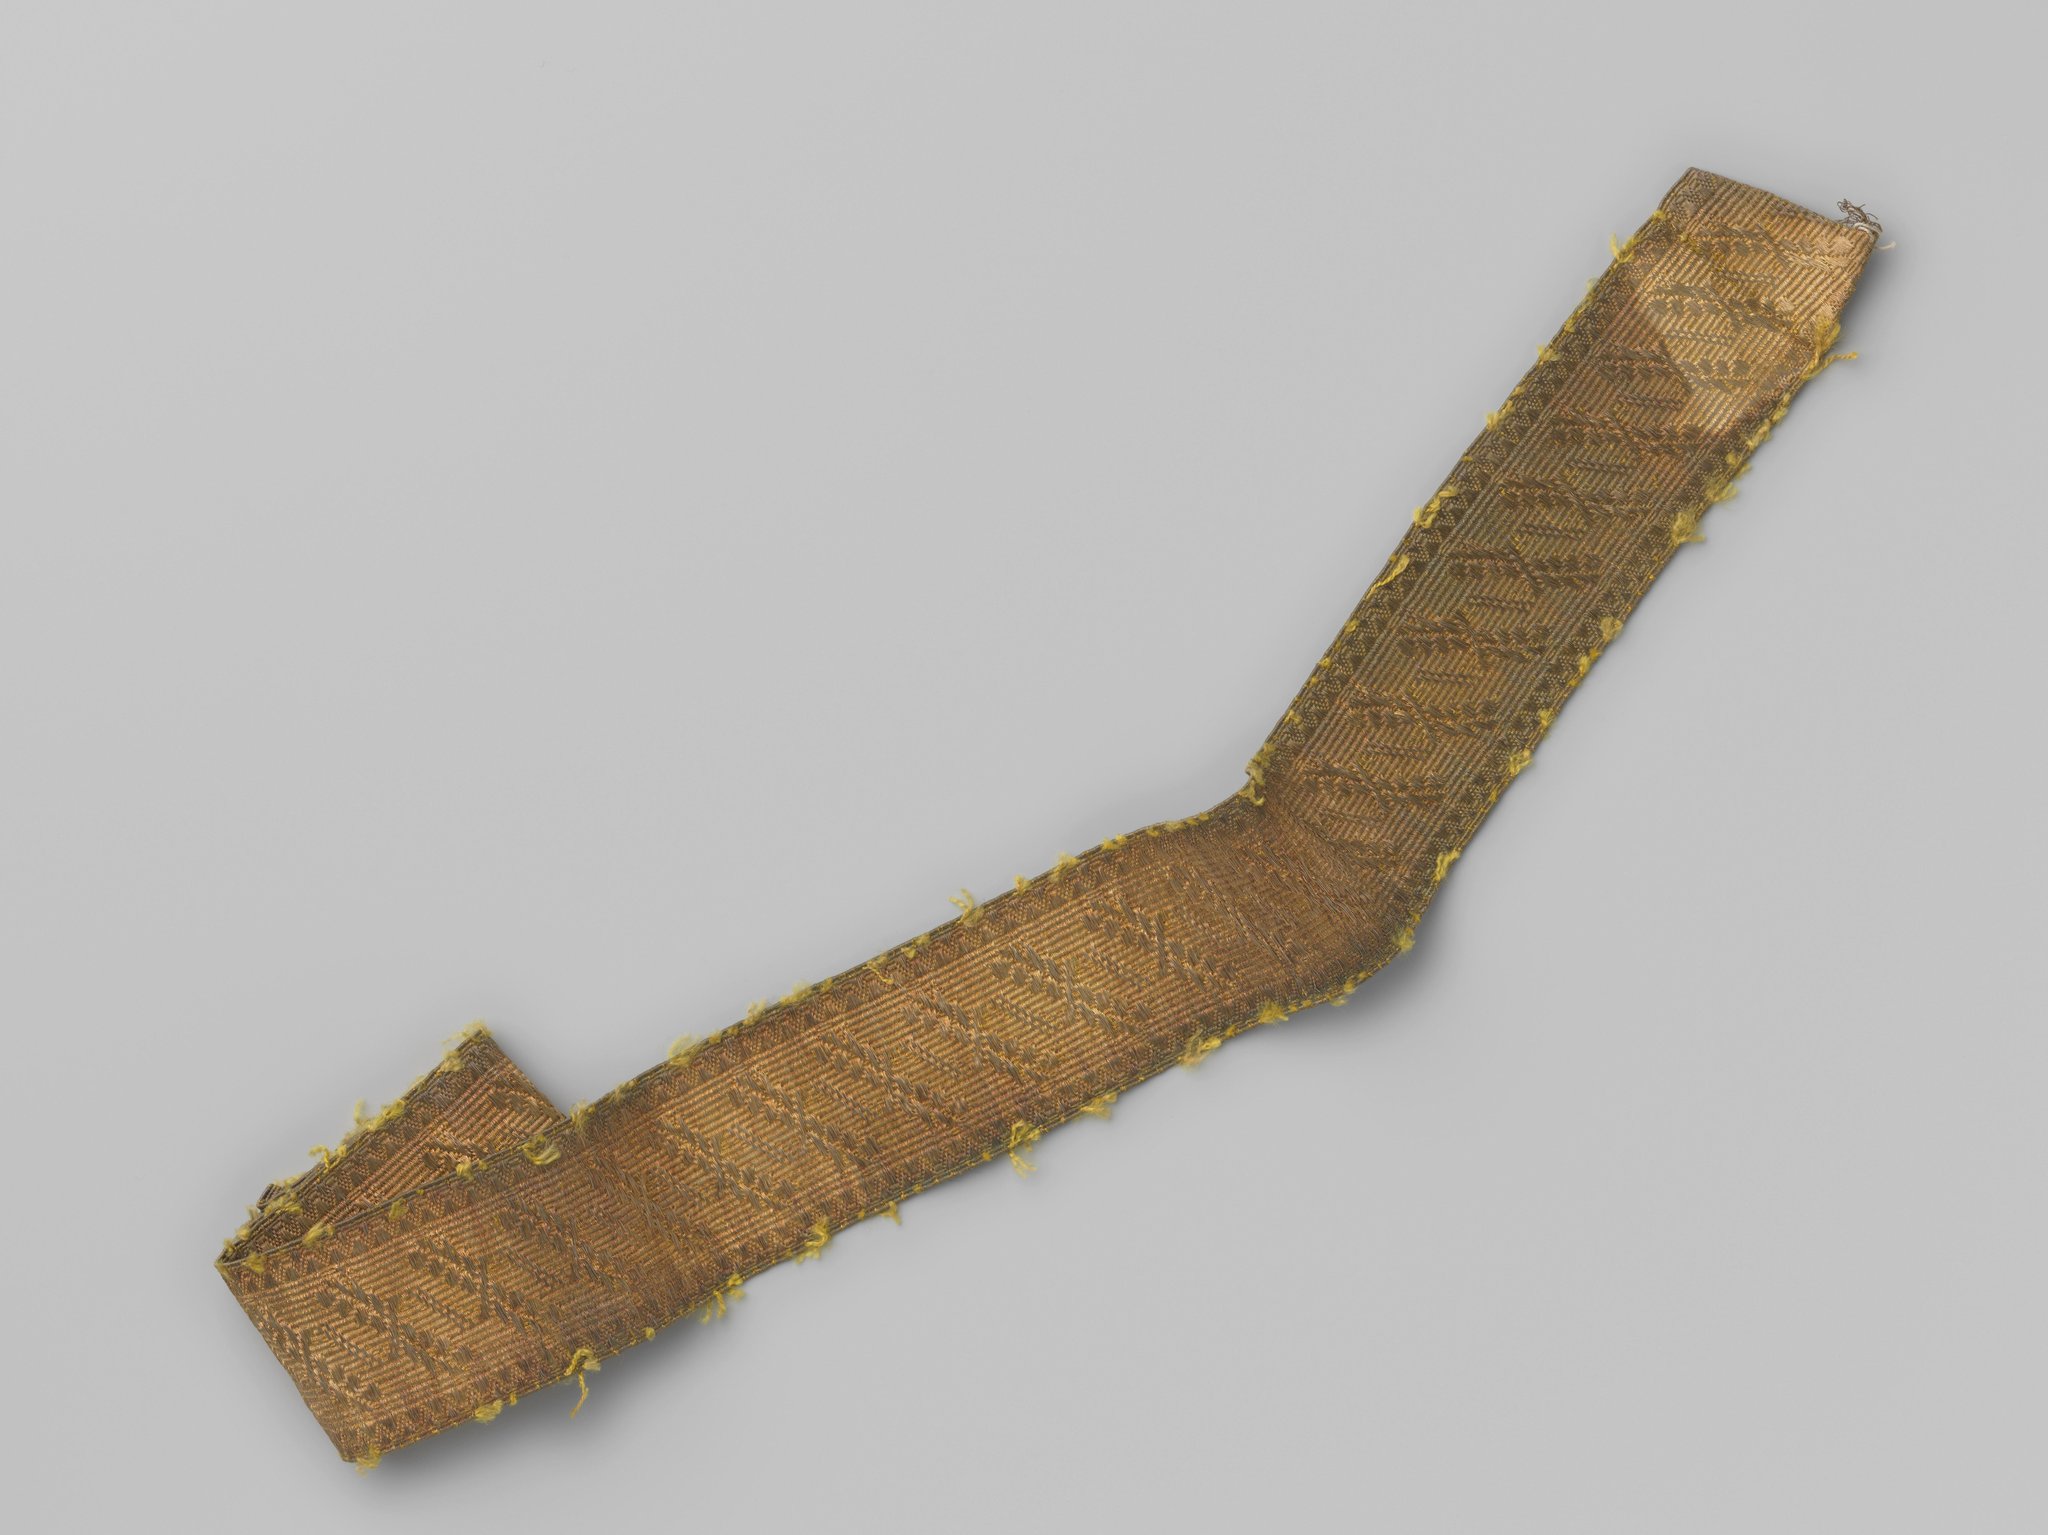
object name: goudgalon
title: Goudgalon voor broek van J.R. Thorbecke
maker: Anonymous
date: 1850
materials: textile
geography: netherlands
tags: the hague, johan rudolf thorbecke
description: J.R. Thorbecke's official uniform as minister of Home Affairs, c. 1850. After the French occupation new official dress was introduced for government and court functionaries. These uniforms were for special occasions. The higher the rank, the more ornate and ample the decoration, all precisely according to the regulations. The wearer footed the bill. In 1825 King William I introduced official dress for ministers. Thorbecke had these garments made, with tricorne and sword, around 1850, during his first ministry.